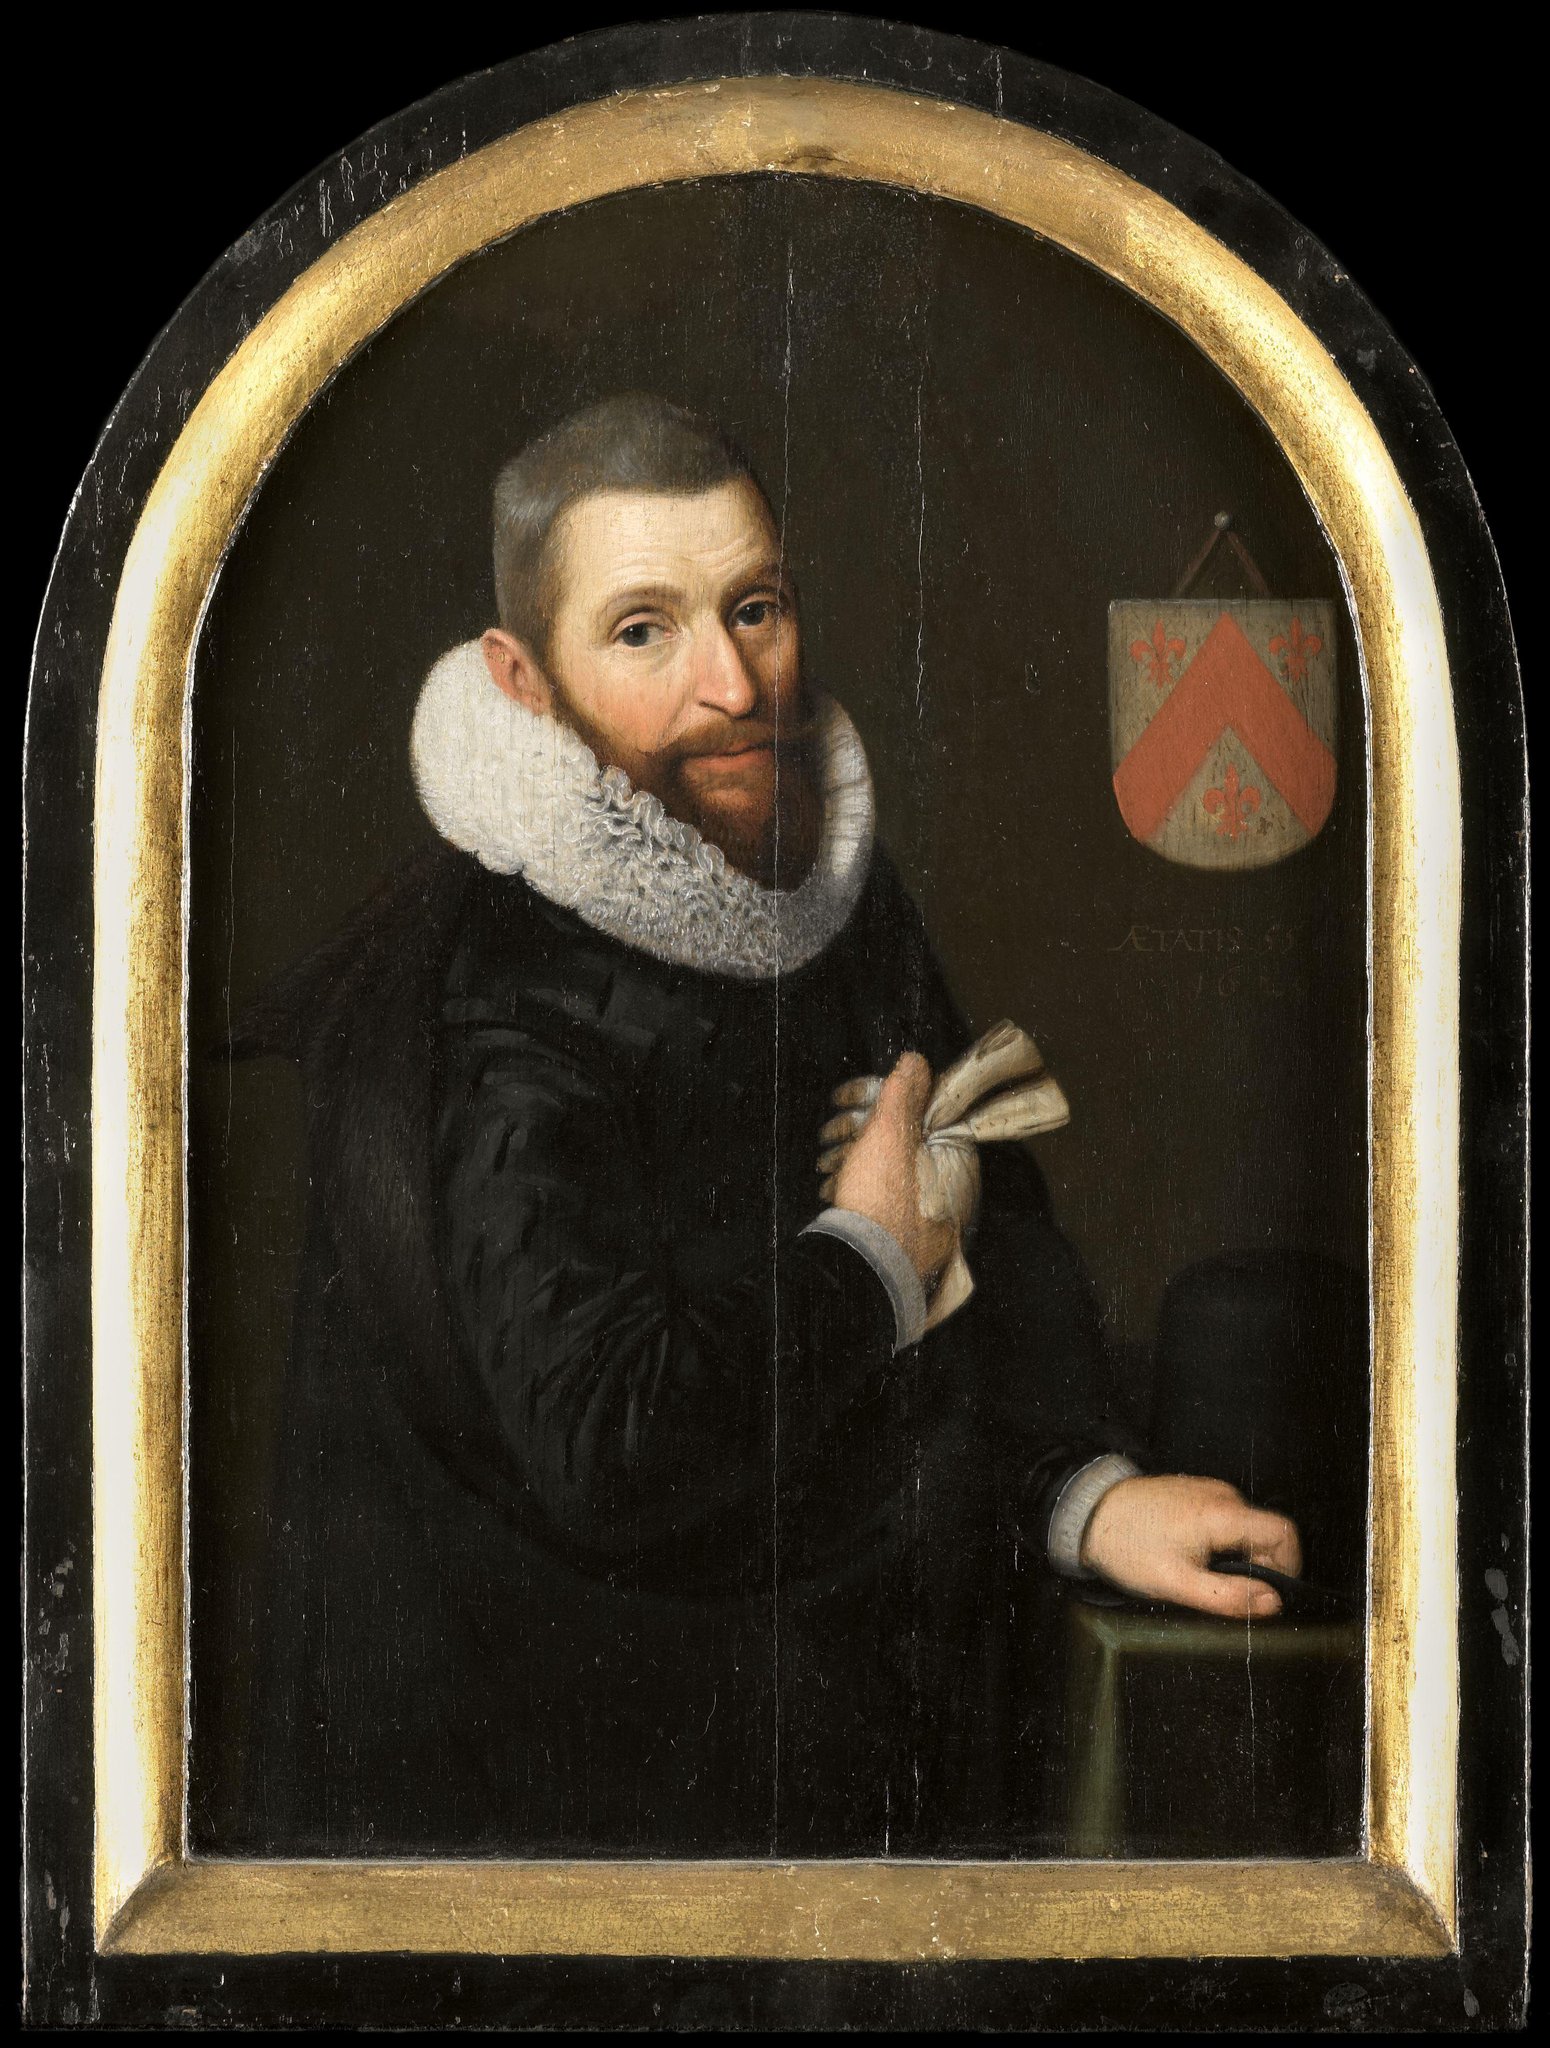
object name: painting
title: Portrait of Johan Gerritsz van Schoterbosch (c. 1564-1654)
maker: cornelis engelsz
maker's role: painter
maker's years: 1574-1650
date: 1620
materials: oil, panel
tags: historical persons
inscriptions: coat of arms, upper right: a red chevron and three red fleurs-de-lis on a silver ground, inscription, centre right: ‘ÆTATIS 55 / 1620’, inscription, on the reverse, in black paint: ‘6 / Mr Floris Overyn van / Schoterbosch geb 1565 / Raadsheer’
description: Portret van Johan Gerritsz. van Schoterbosch, raad en schepen van Haarlem, kapitein van de Kloveniersdoelen, president van het St. Hubertusgilde en broder van het H. Kerstmisgilde. Heupstuk, handschoenen in de rechterhand, de linkerhand rustend op een tafeltje. Herhaling van een werk uit 1619. Met geïntegreerde lijst. Vormt een serie met de nummers SK-A-4771/4775.